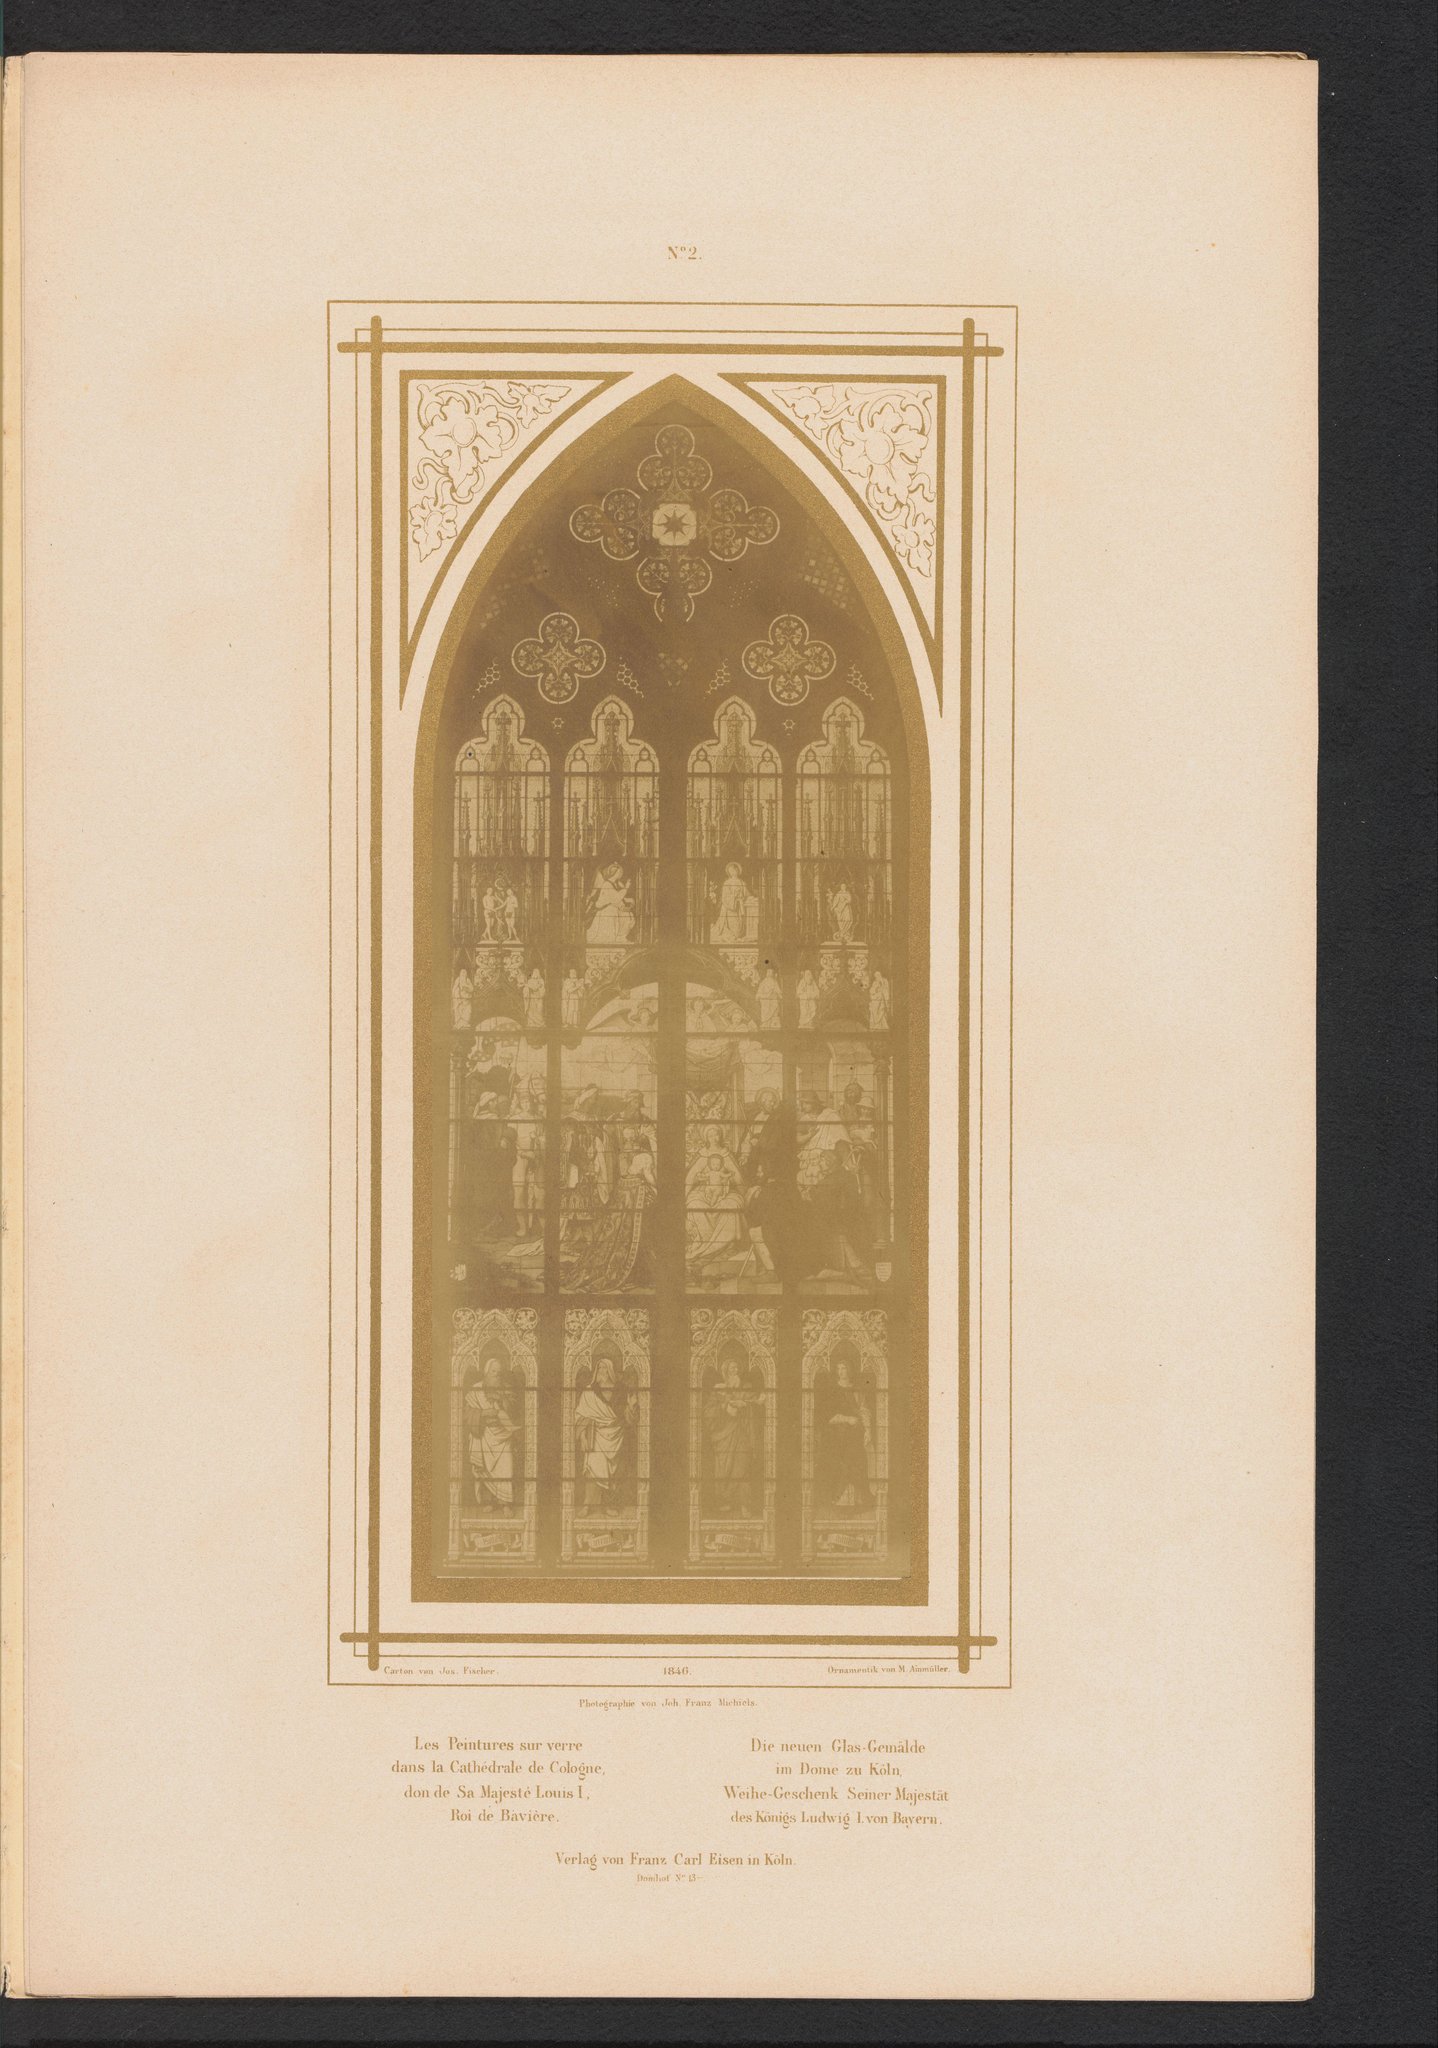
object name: photograph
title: Gebrandschilderd raam ontworpen door Max Emanuel Ainmiller, in de Dom van Keulen, Duitsland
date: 1849-1854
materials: photographic support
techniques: albumen print, lithograph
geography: cologne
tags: church-window, e.g. rose-window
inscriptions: number: ‘No 2.’, inscription: ‘Ornamentik von M. Ainmüller.’, inscription: ‘Les Peintures sur verre/ dans la Cathédrale de Cologne,/ don de Sa Majesté Louis I,/ Roi de Bavière.’, date: ‘1846.’, inscription: ‘Die neuen Glas-Gemälde/ im Dome zu Köln,/ Weihe-Geschenk Seiner Majestät/ des Königs Ludwig I von Bayern.’, inscription: ‘Carton von Jos. Fischer.’, address: ‘Domhof No 13-.’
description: Deze foto maakt deel uit van een omslag met vijf foto's en één tekstblad.